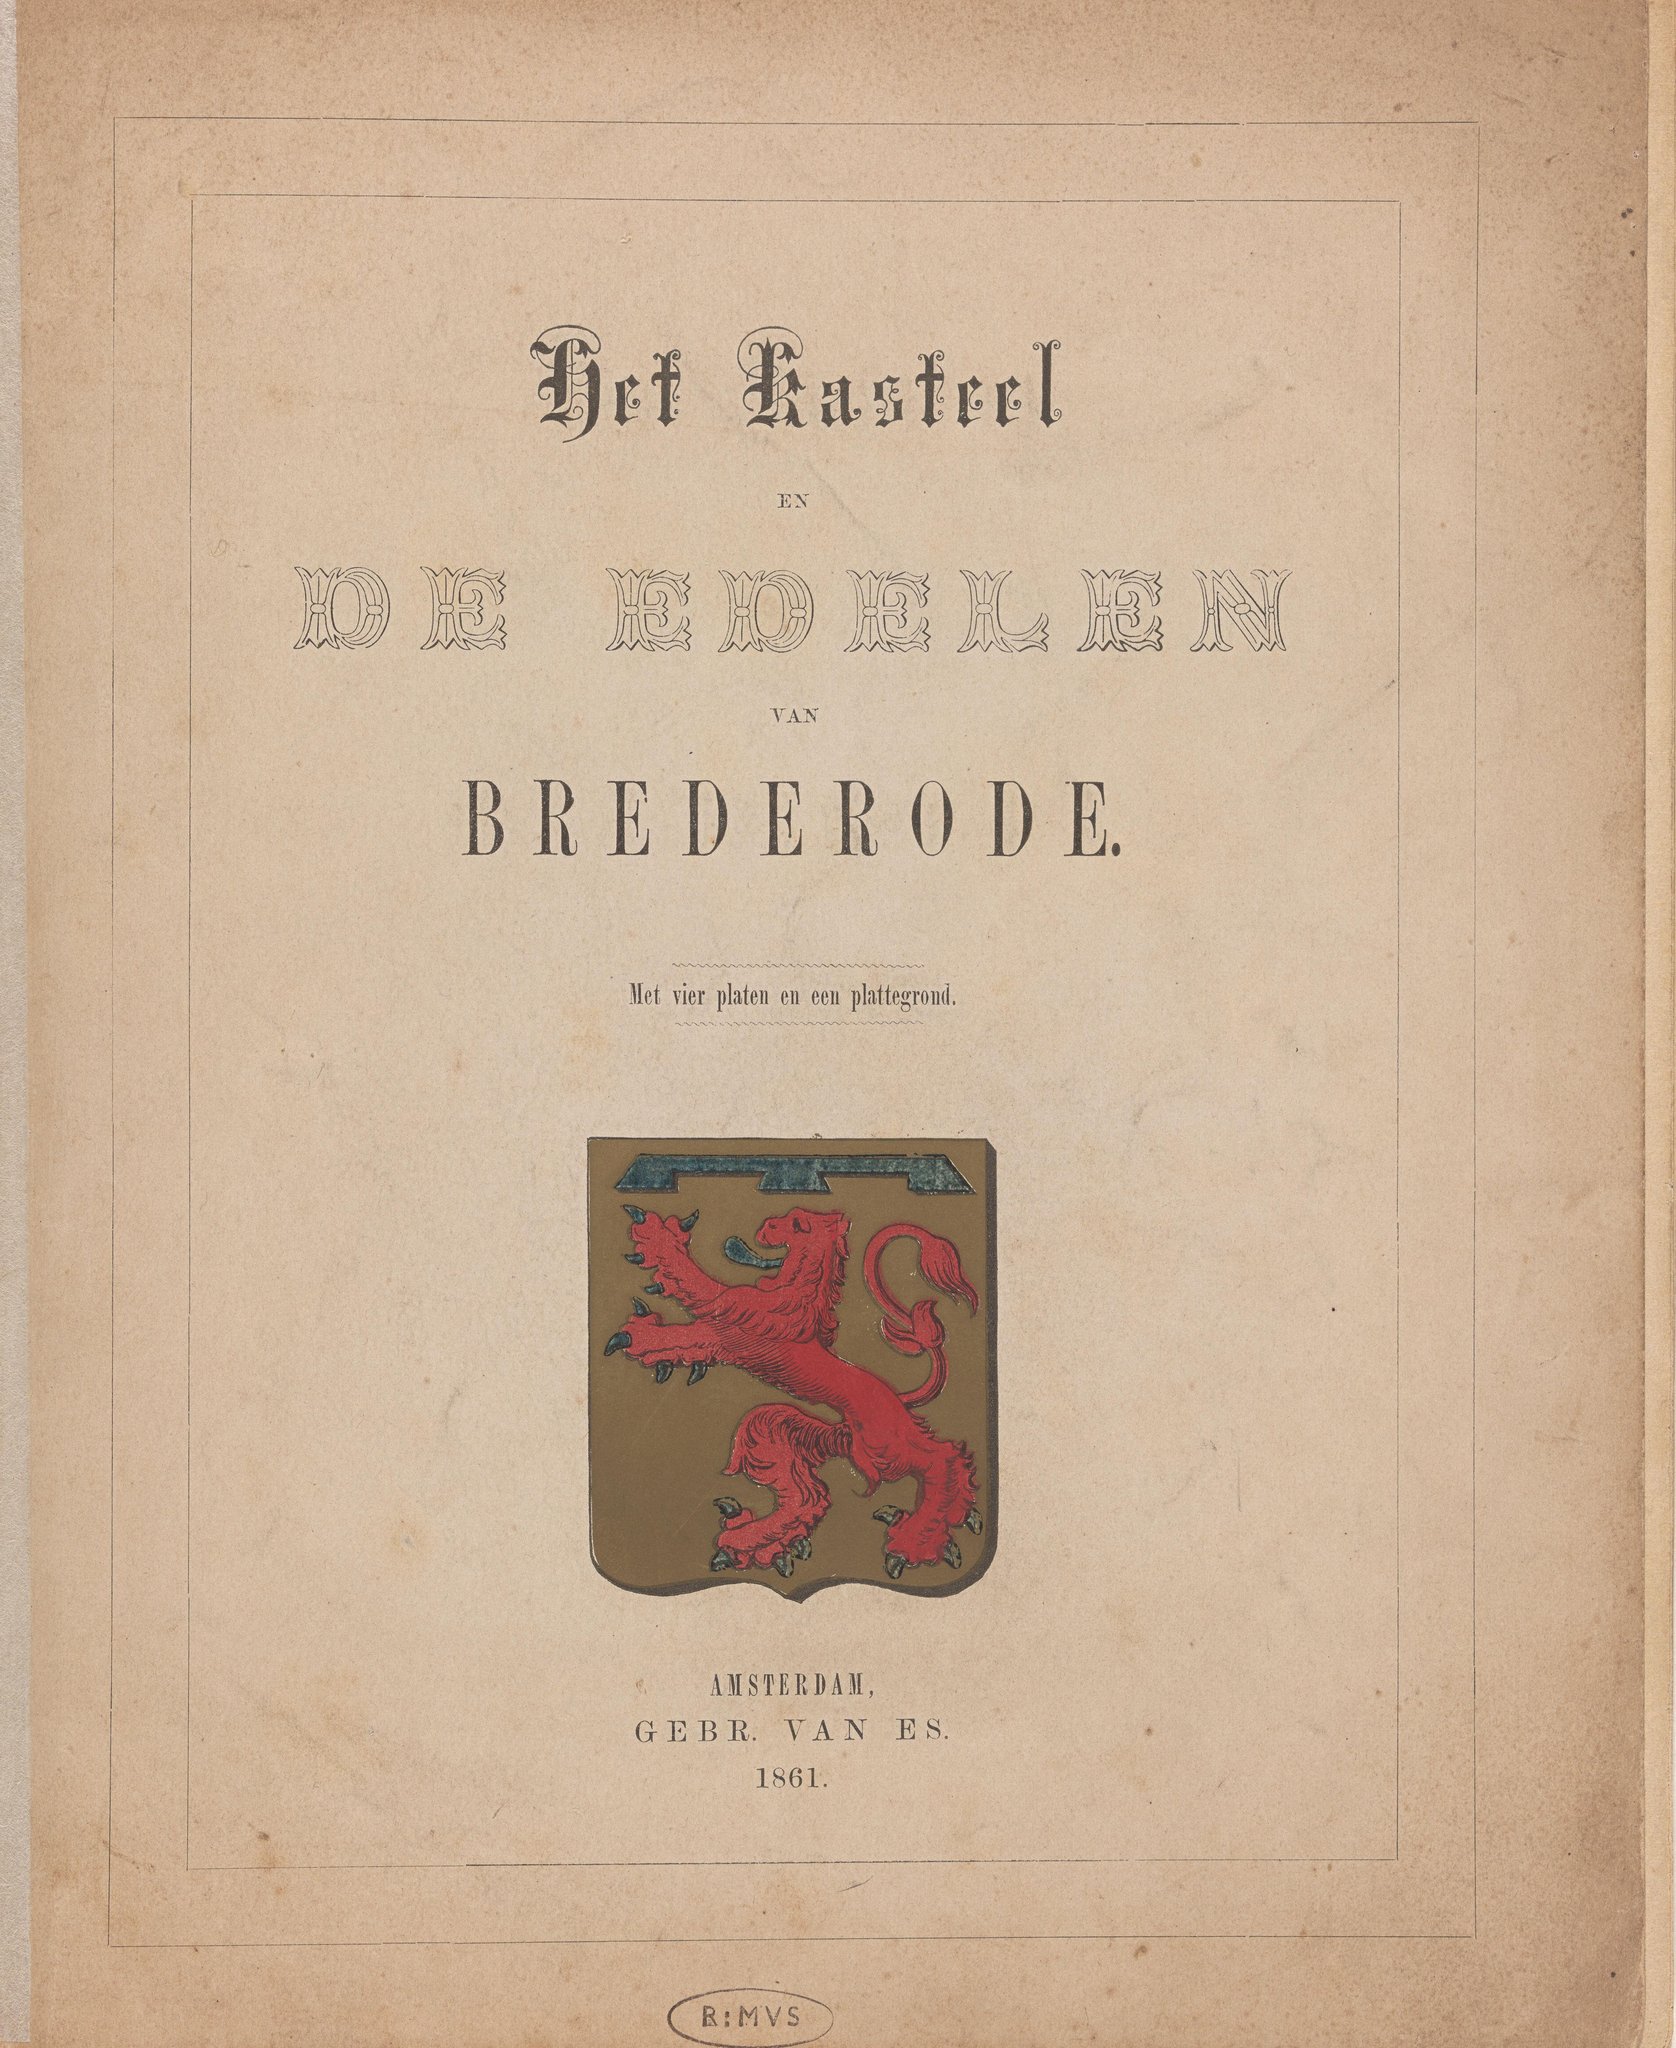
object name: print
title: Titelpagina voor: Willem Jacob Hofdijk, Het kasteel en de edelen van Brederode, 1861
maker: isaac weissenbruch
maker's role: print maker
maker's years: 1826-1912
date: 1861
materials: paper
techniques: letterpress printing, engraving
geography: netherlands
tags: gate, entrance, courtyard, plan ~ architecture, ruin of a dwelling, house, castle, etc.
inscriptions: collector's mark: Lugt 2228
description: Boekje met een titelpagina en vier prenten gemaakt door Isaac Weissenbruch en uitgegeven door Gebr. van Es te Amsterdam in 1861.